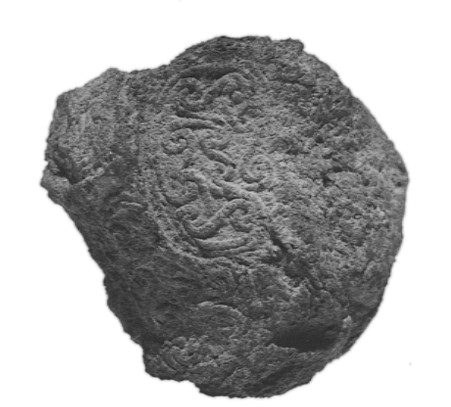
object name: sealing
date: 2030-1640 BCE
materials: clay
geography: egypt